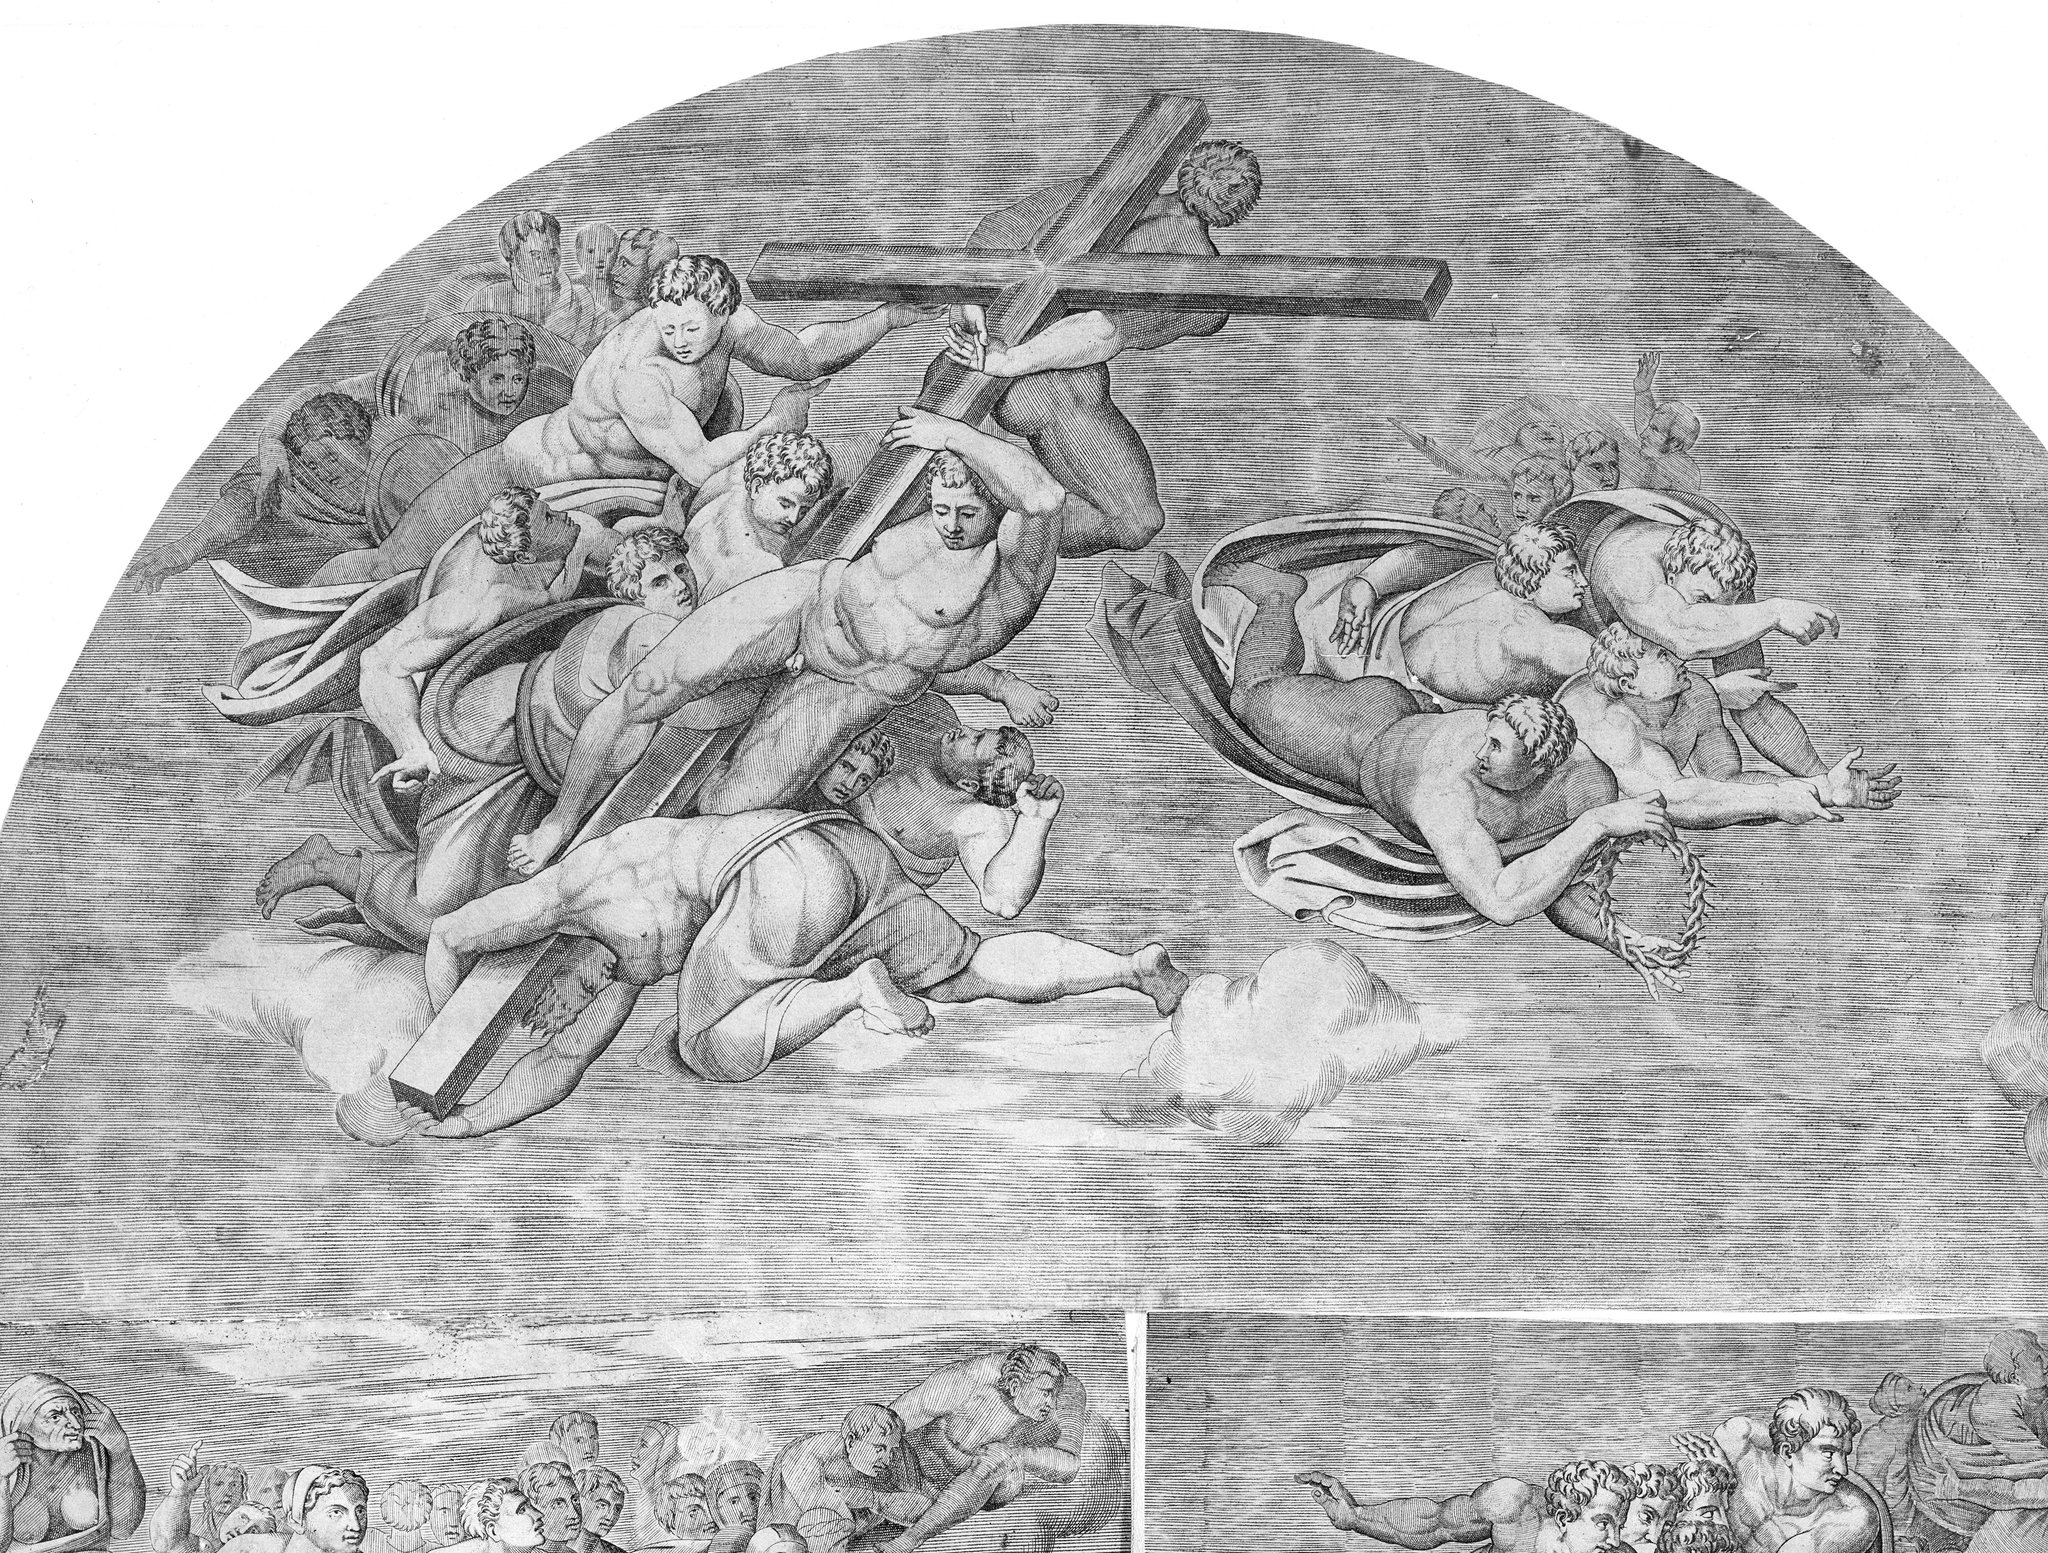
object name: print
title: Angels Carrying the Cross with Saints below (upper left section of the Last Judgment)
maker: niccolò della casa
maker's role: artist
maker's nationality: french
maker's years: 1543-1548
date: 1548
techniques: engraving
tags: angels,cross,saints